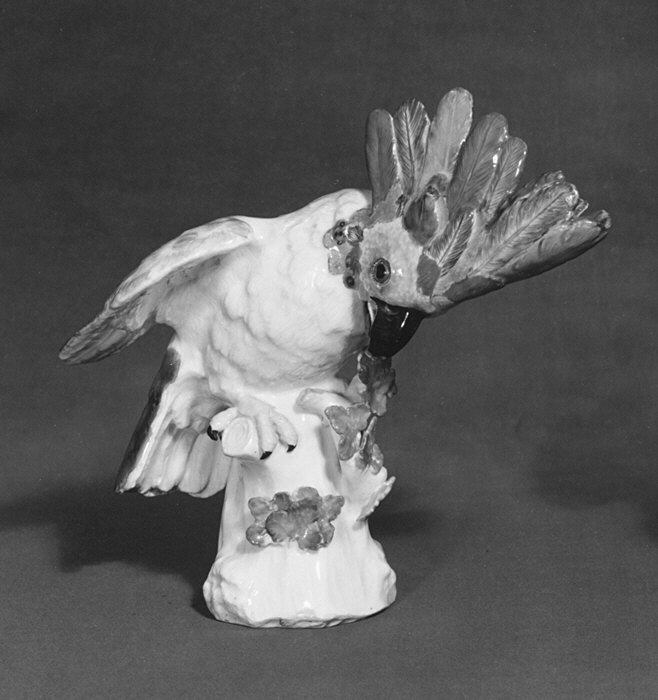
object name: figure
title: Cockatoo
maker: meissen manufactory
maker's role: manufactory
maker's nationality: german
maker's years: 1710-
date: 1740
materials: hard paste porcelain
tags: birds